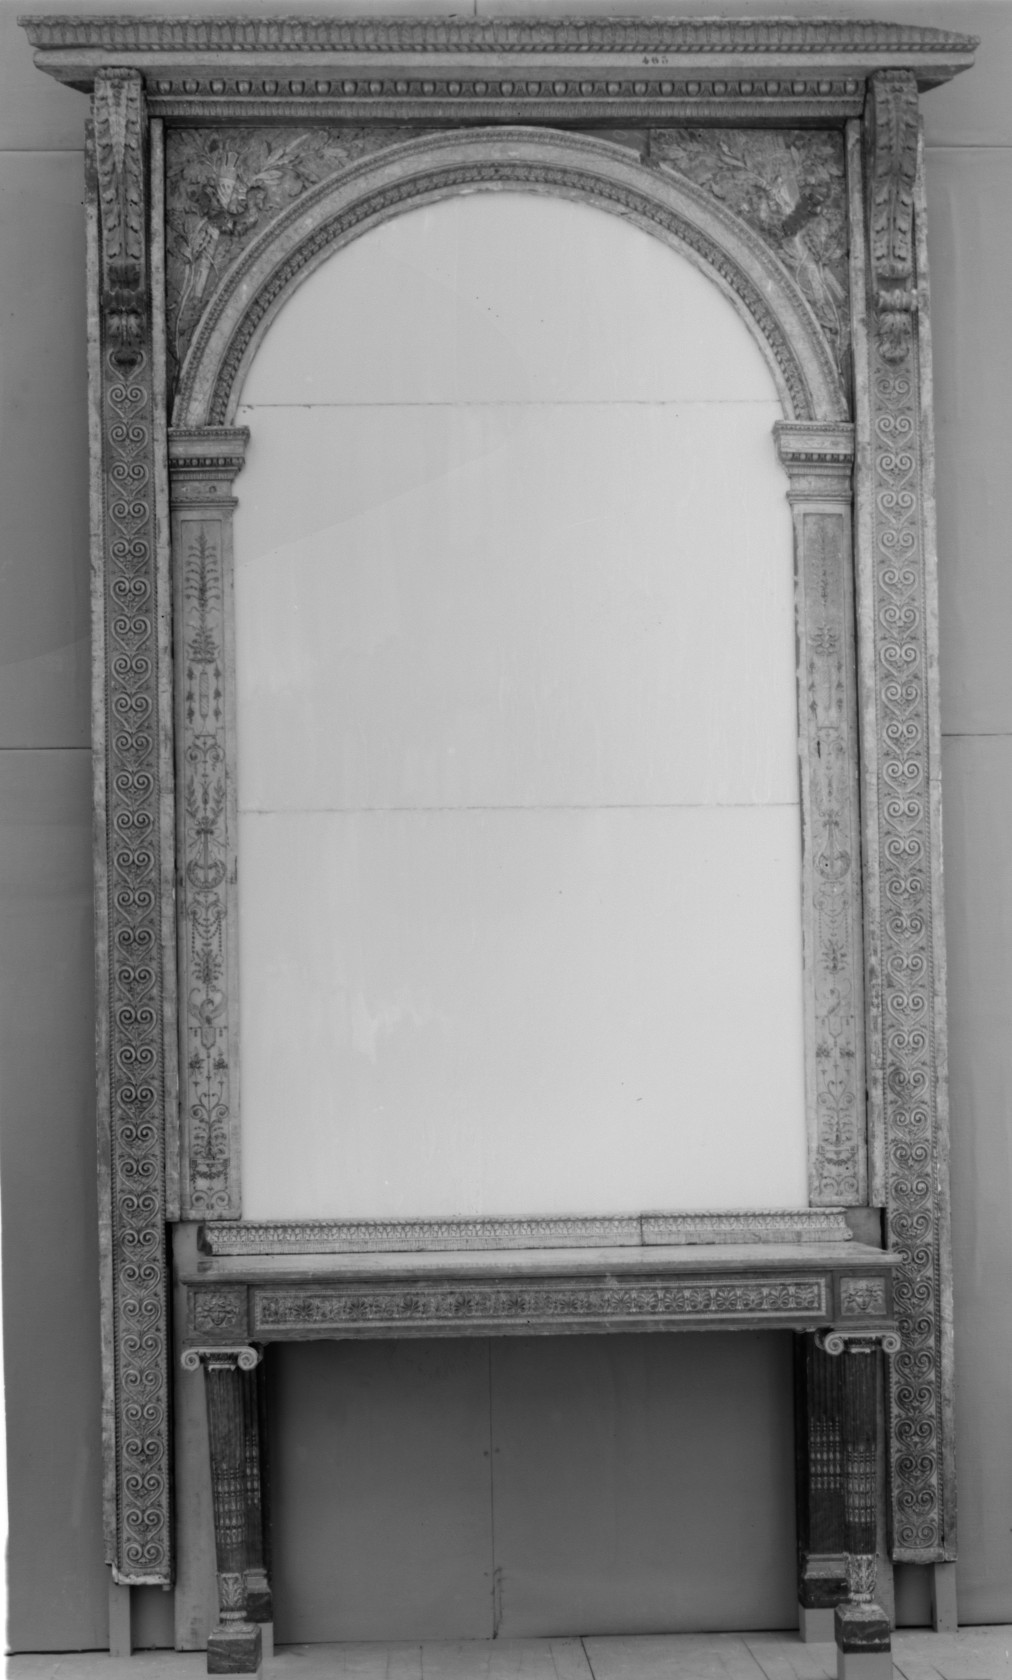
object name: side table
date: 1701-1800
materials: marble, wood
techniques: carving, gilding, painting